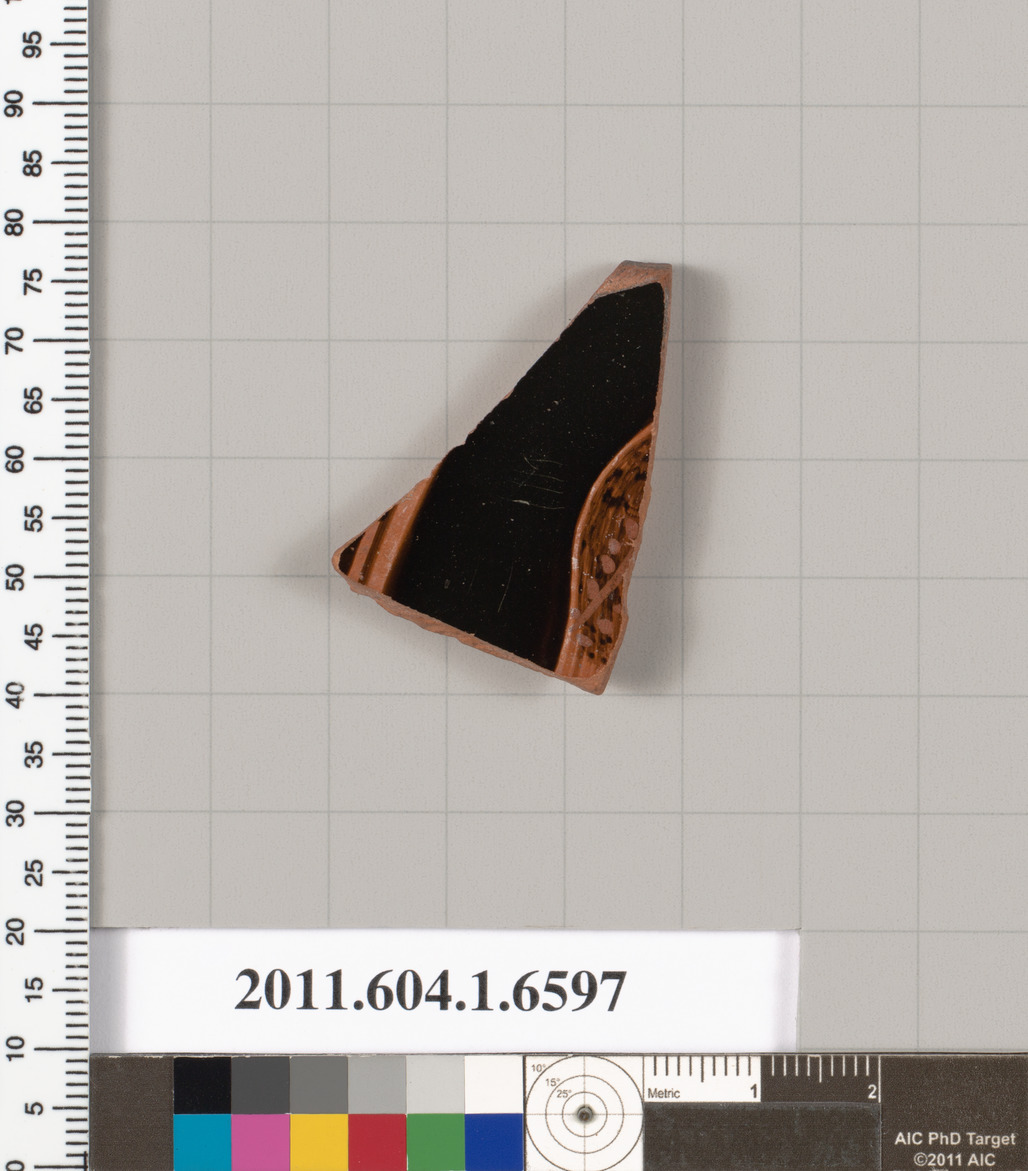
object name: kylix fragment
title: Terracotta fragment of a kylix (drinking cup)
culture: greek, attic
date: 490-480 BCE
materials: terracotta